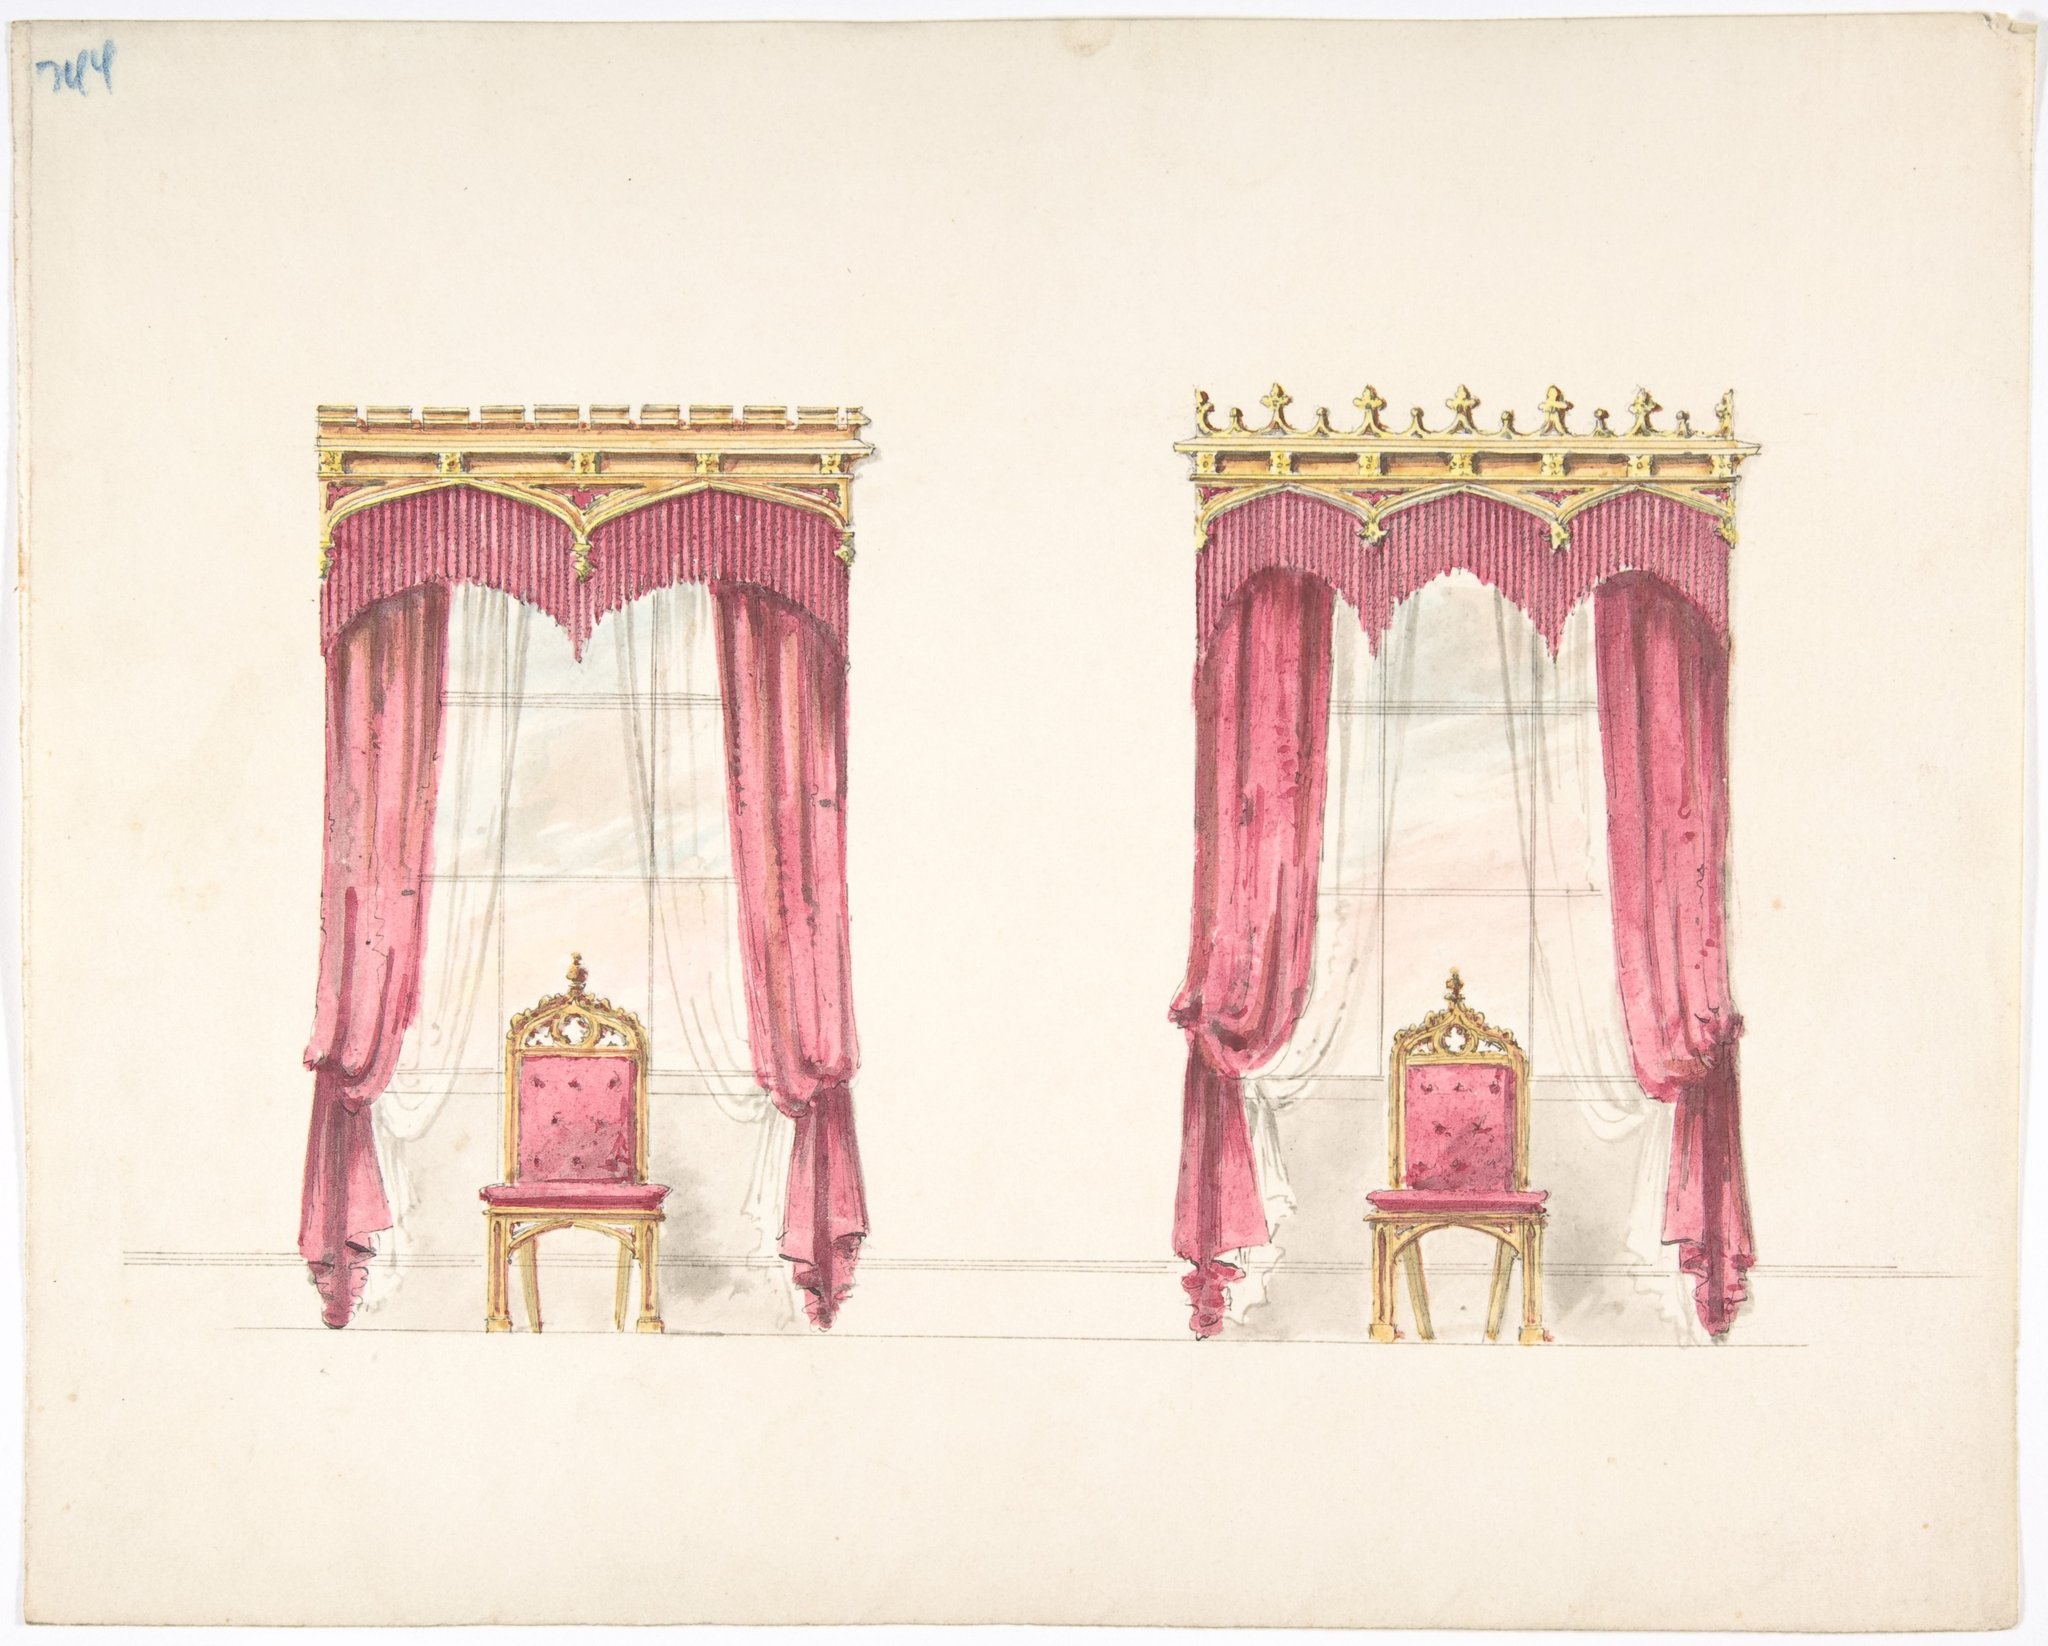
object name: drawing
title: Design for Two Red Fringed Curtains with Gold Pelmets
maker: anonymous, british, 19th century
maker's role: artist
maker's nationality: british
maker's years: 1800-1900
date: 1801-1833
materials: ink, watercolor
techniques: brush, pen, wash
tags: windows,curtains